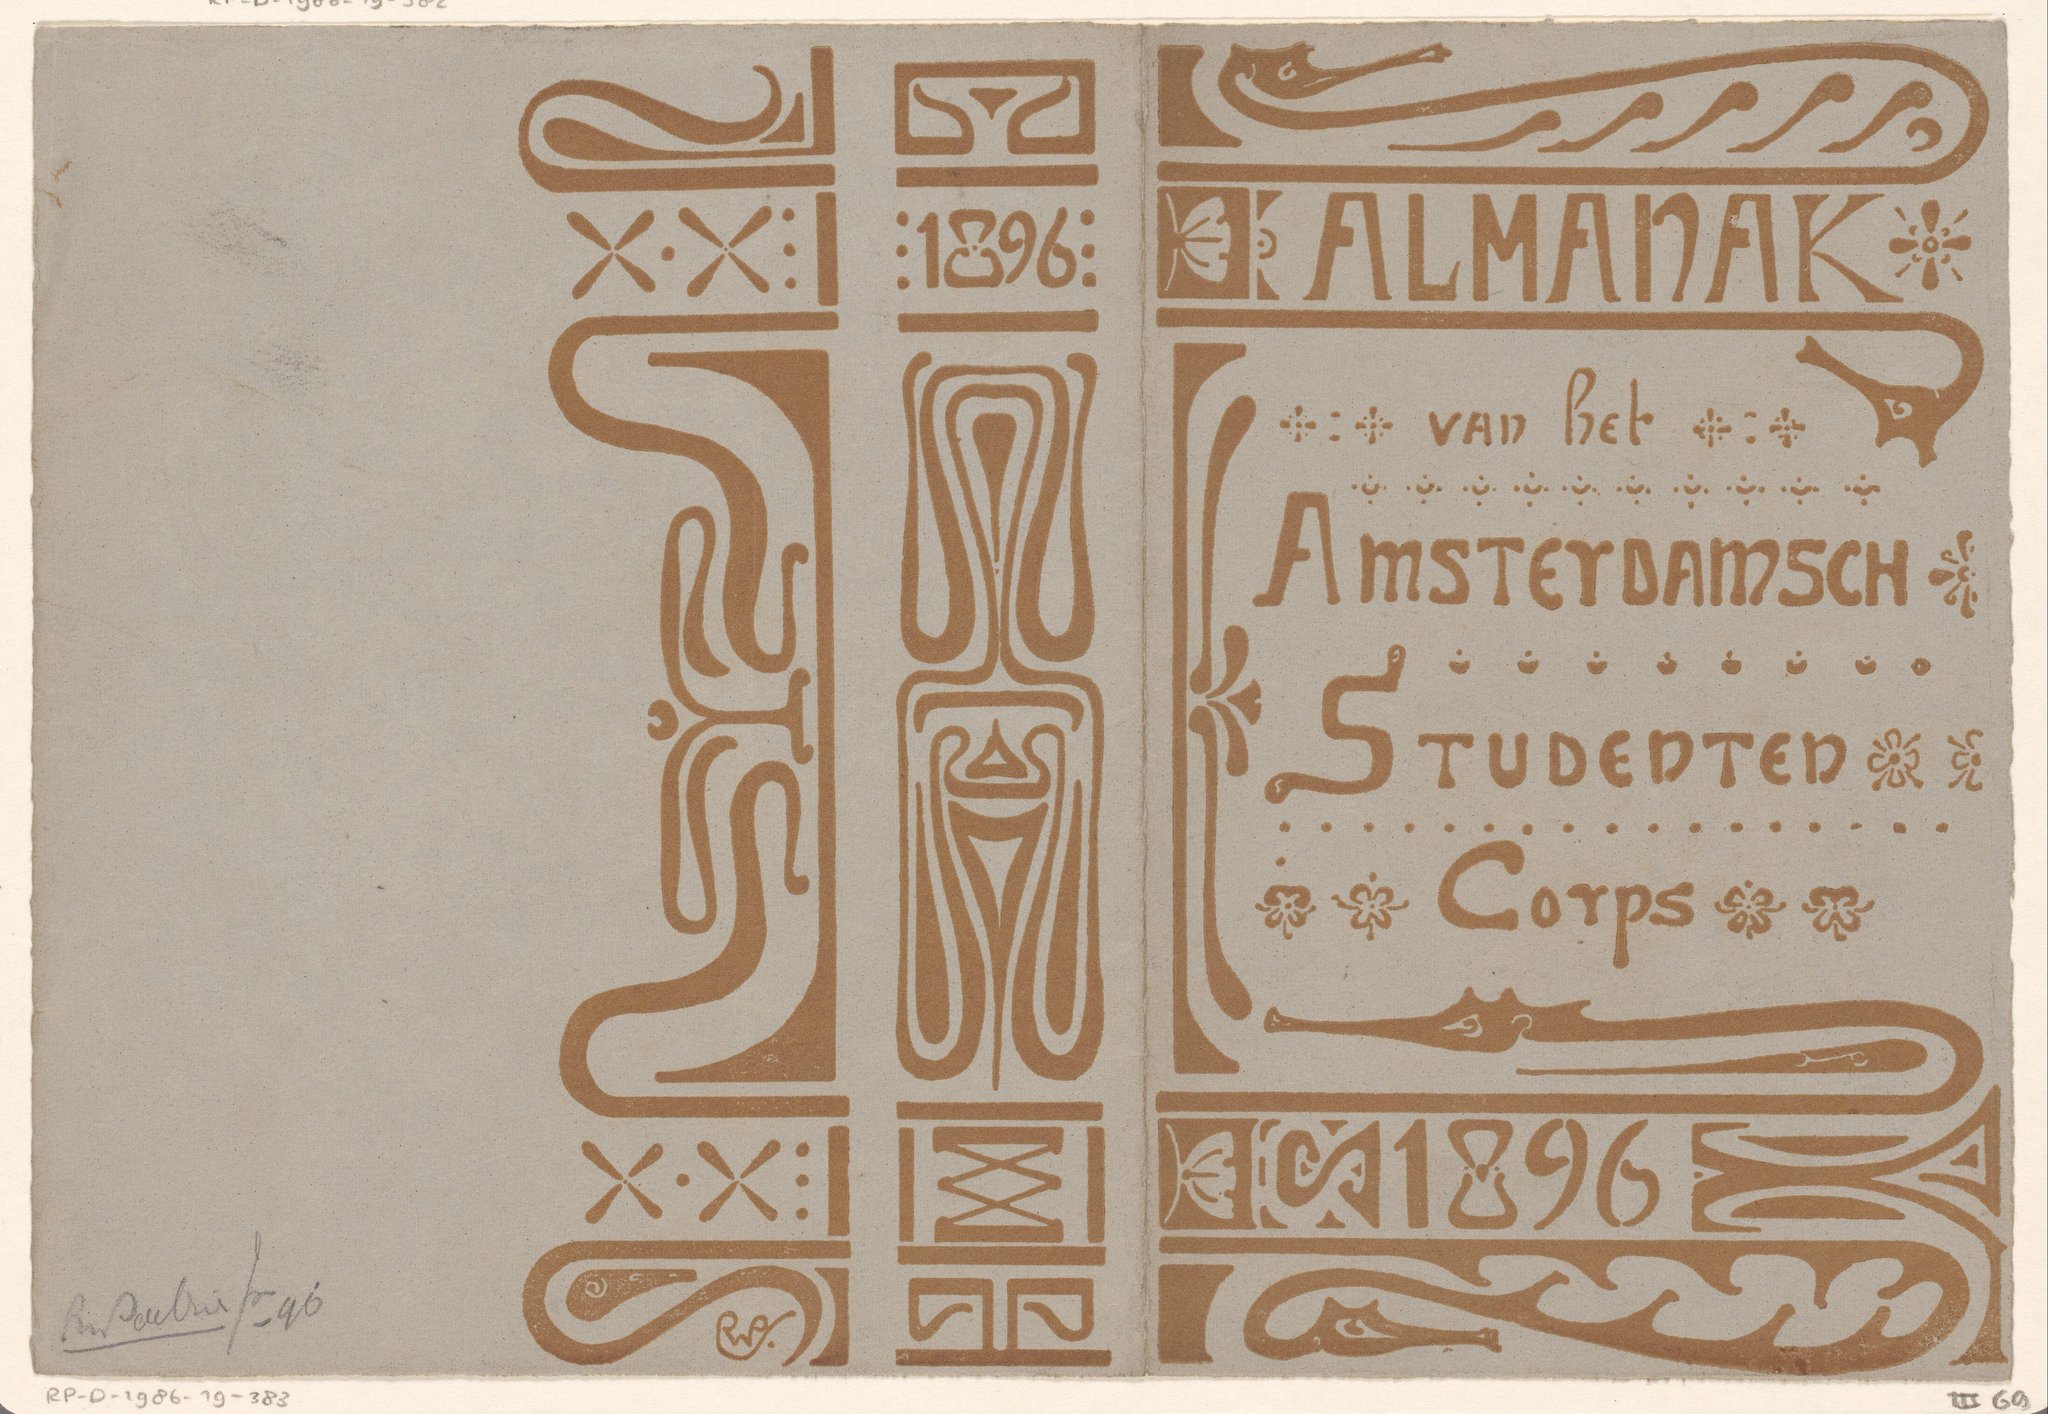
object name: study for binding design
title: Bandontwerp voor: Almanak van het Amsterdamsch Studenten Corps, 1896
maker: reinier willem petrus de vries (1874-1953)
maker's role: draughtsman, print maker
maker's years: 1874-1953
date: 1896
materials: paper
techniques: printing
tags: ornament ~ combination of straight and curved lines, flowers ~ ornament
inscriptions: collector's mark: ‘R:MVS.’, name: ‘RWPdeVriesf96’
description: Bandontwerp voor: Almanak van het Amsterdamsch Studenten Corps. 66e jaargang. S.l.s.n., 1896.